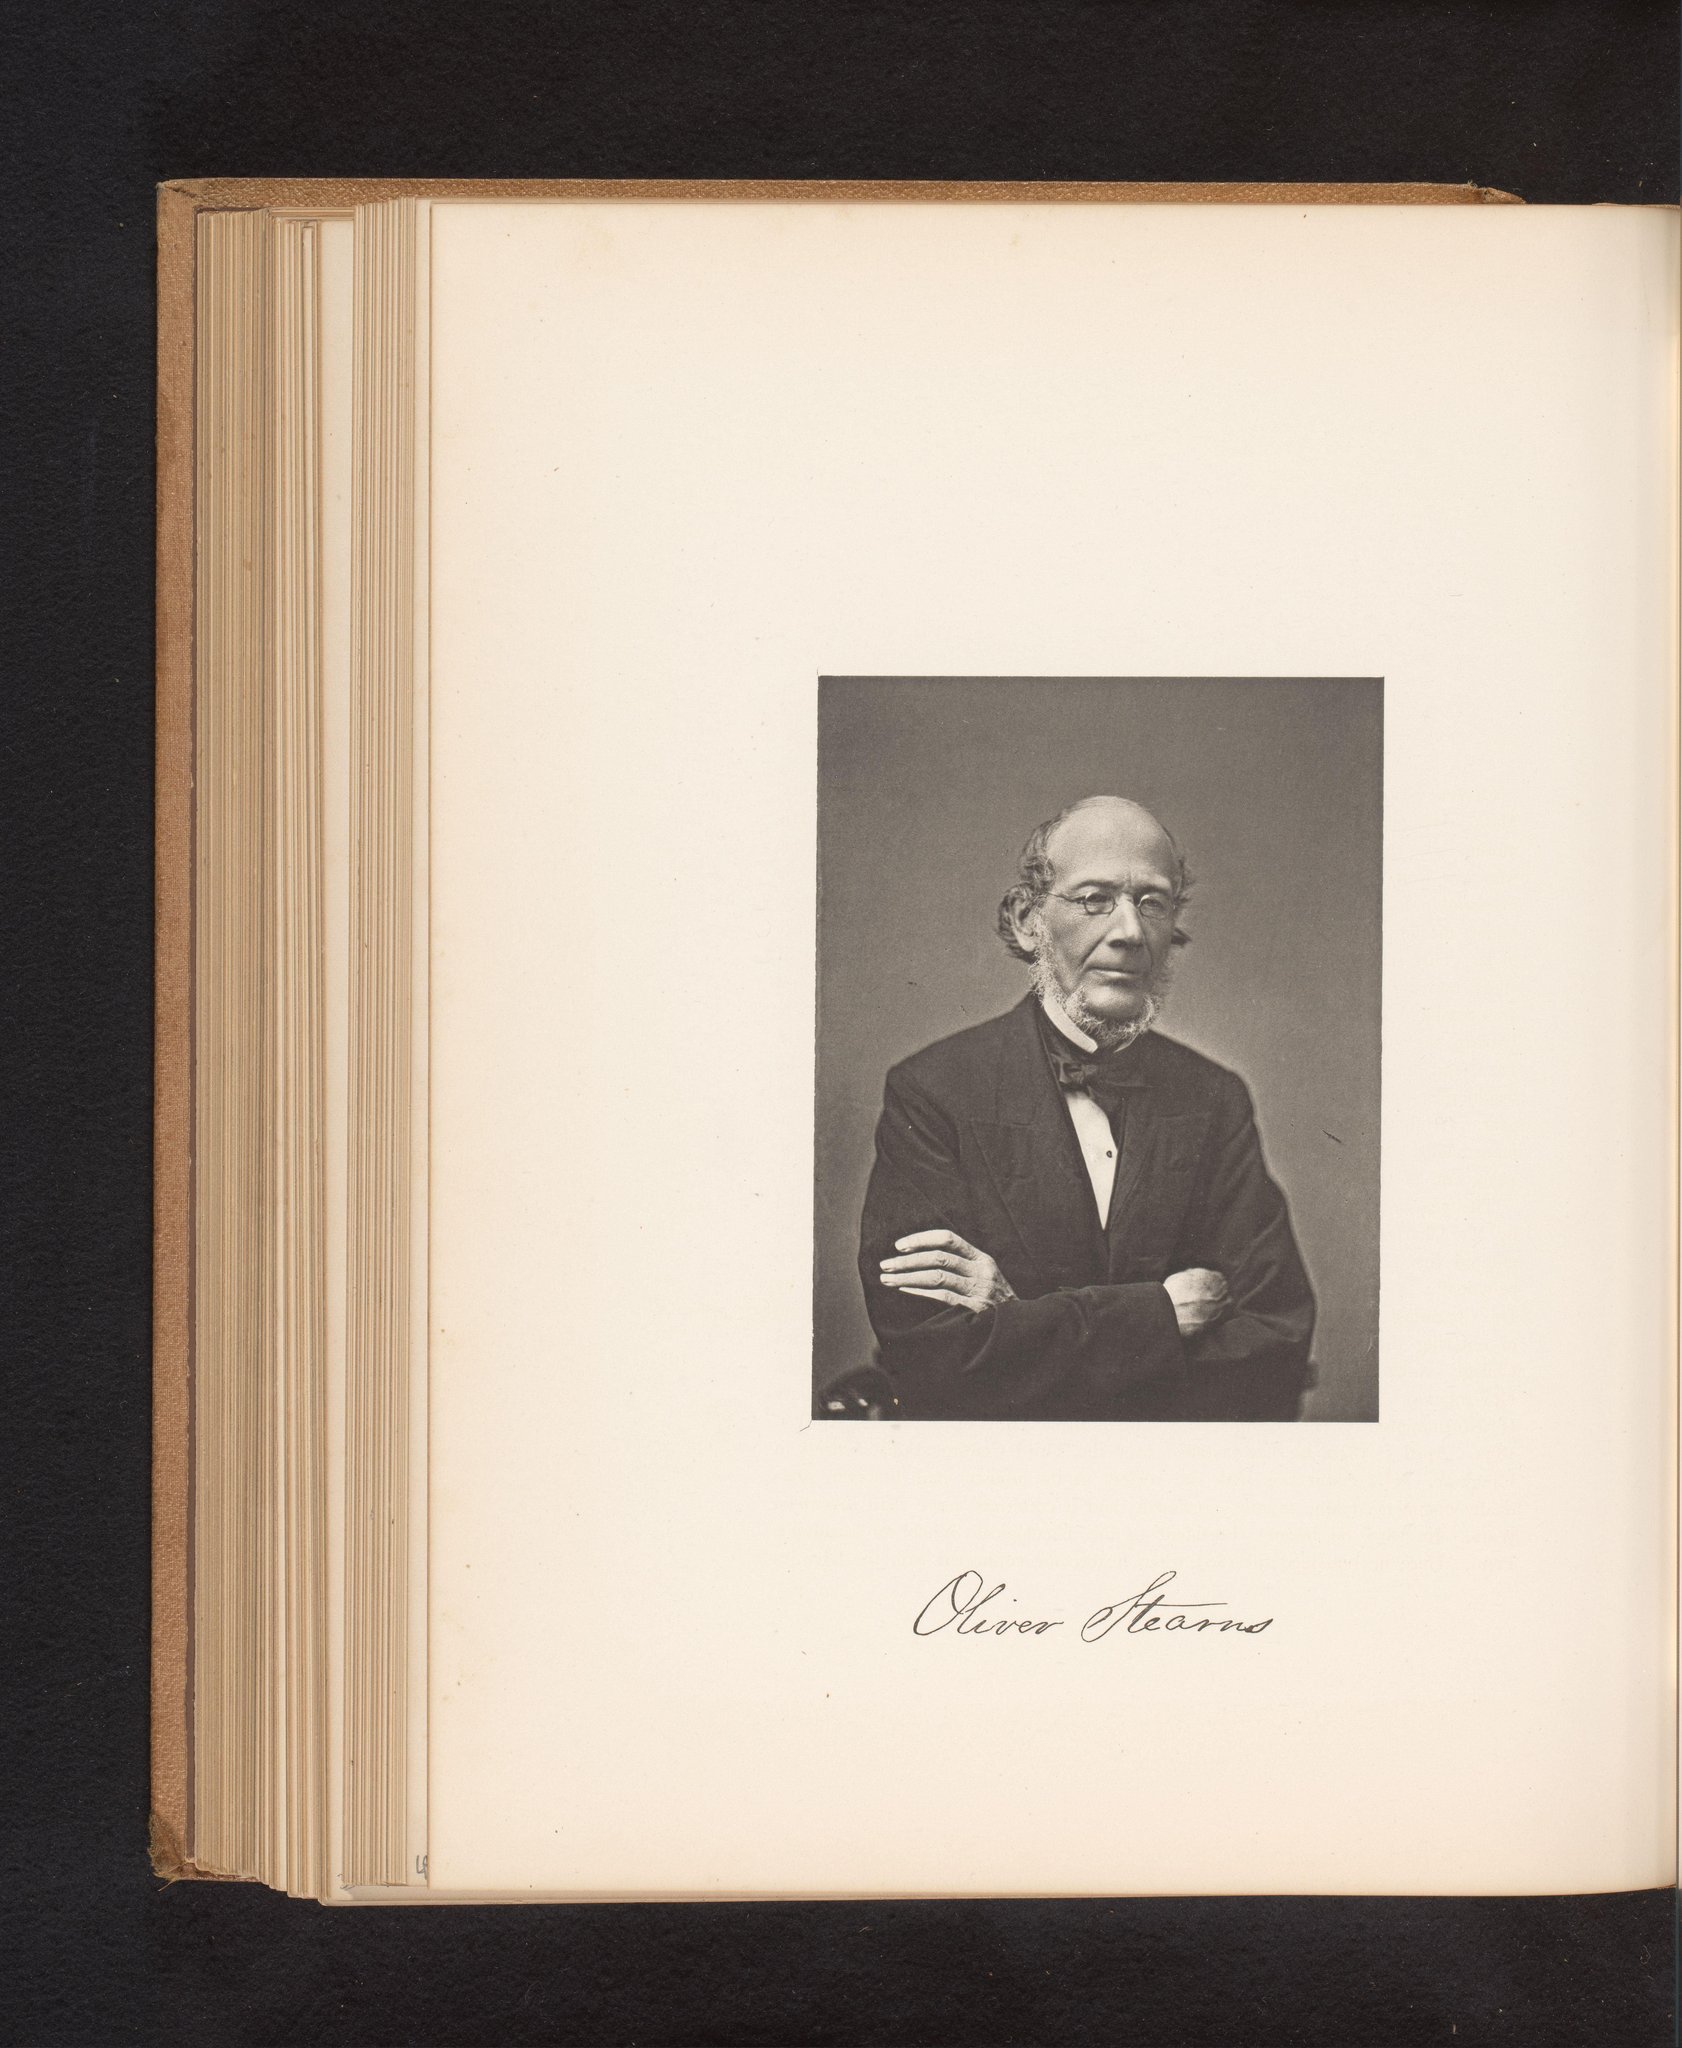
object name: photomechanical print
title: Oliver Stearns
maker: Anonymous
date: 1870-1875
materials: paper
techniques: photograph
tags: historical persons, writer, poet, author